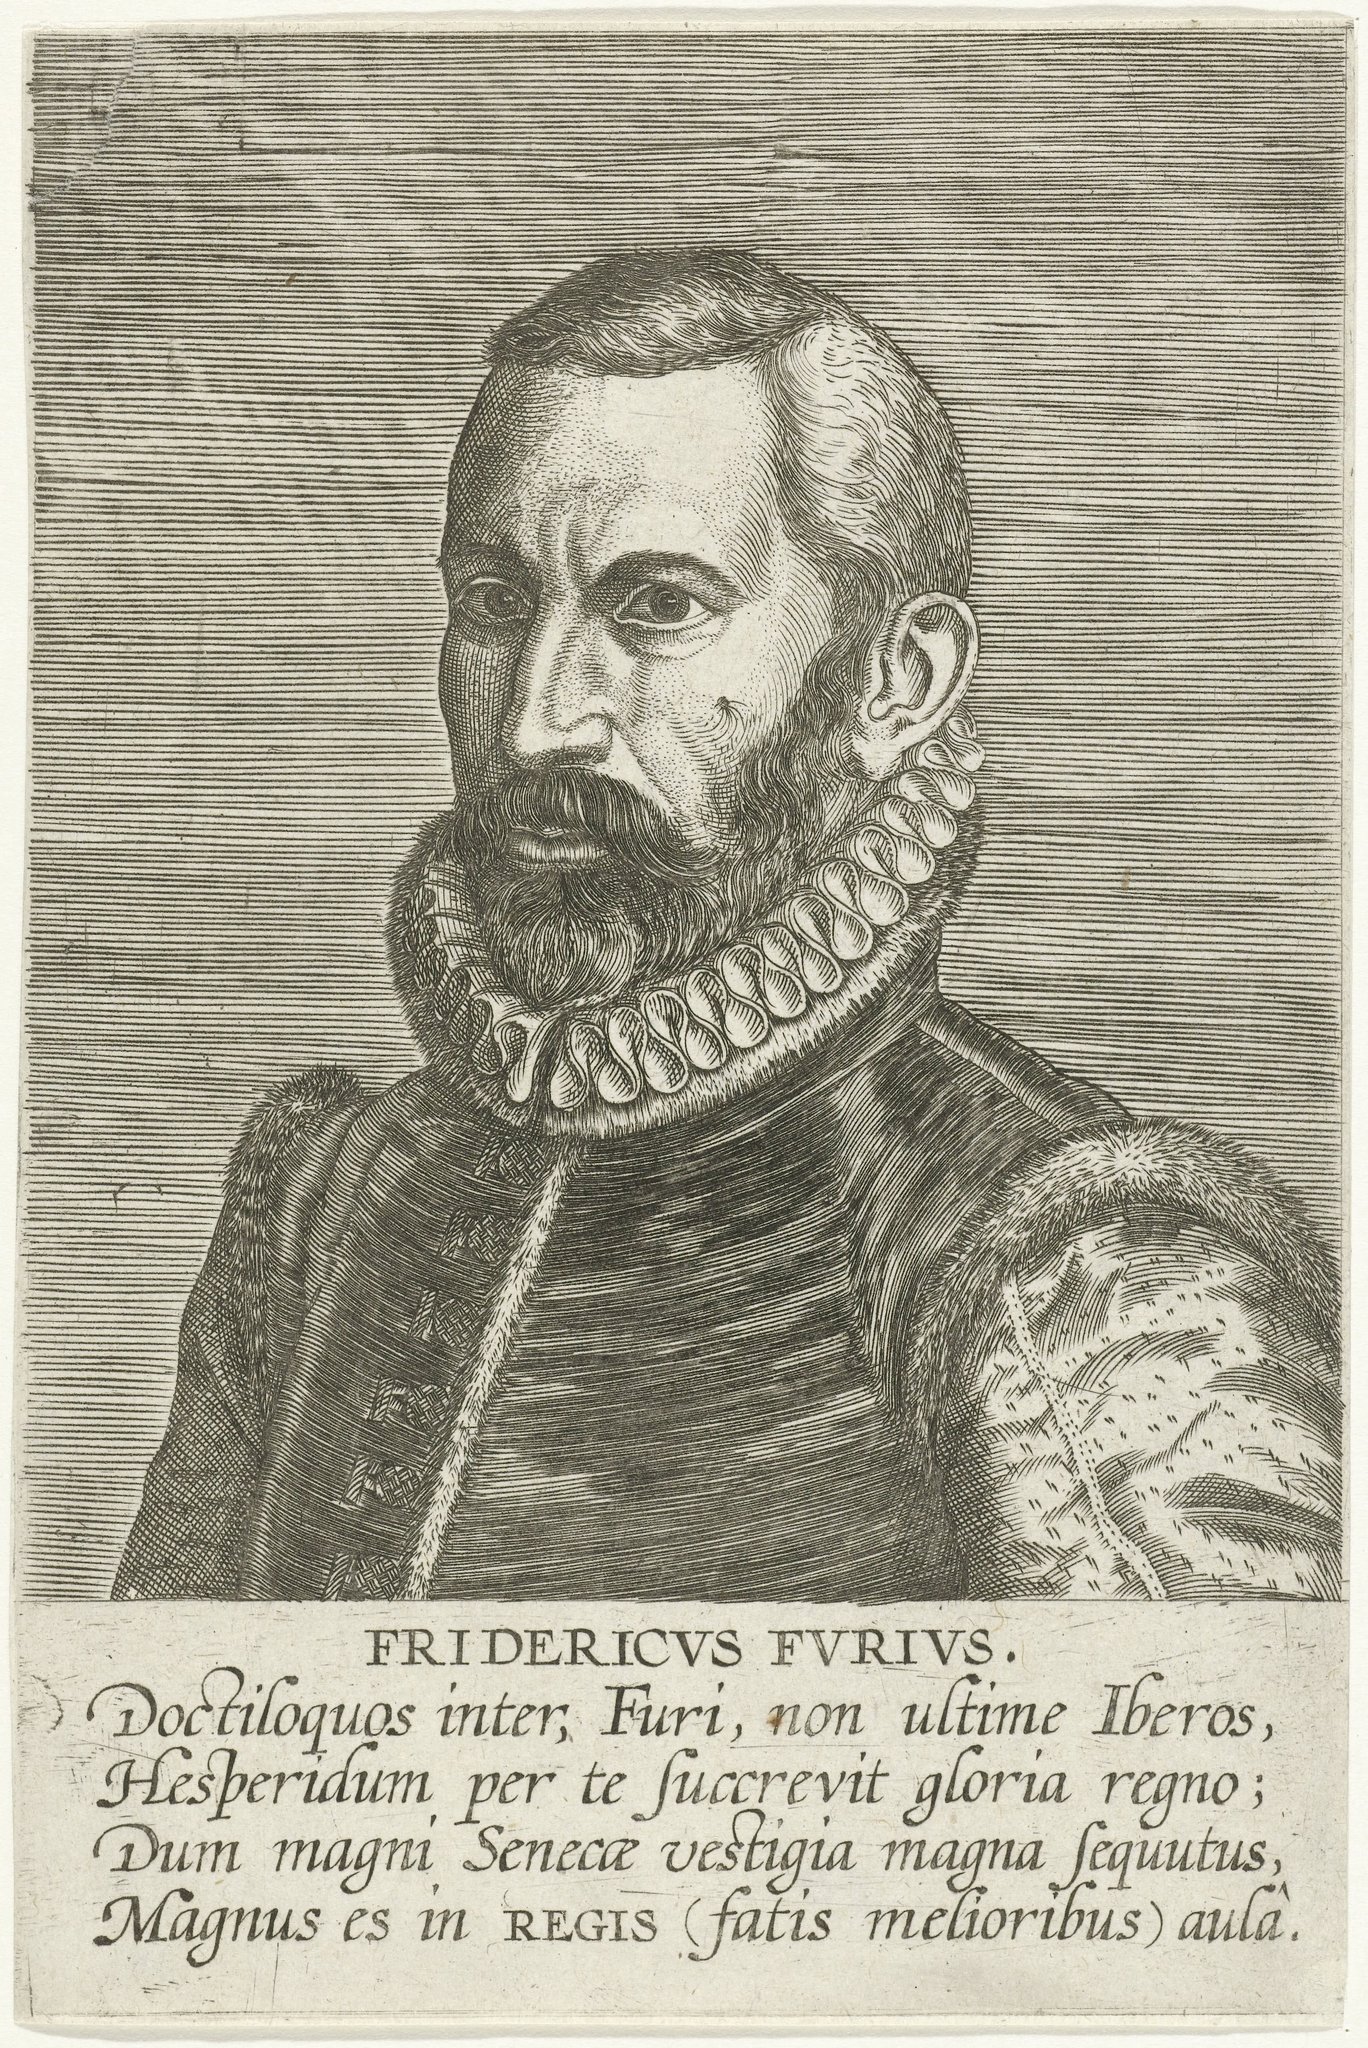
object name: print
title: Portret van Federico Furio y Ceriol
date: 1587-1606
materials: paper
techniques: engraving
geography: antwerp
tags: valencia, valladolid, historicus, federico furio y ceriol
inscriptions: collector's mark: Lugt 2228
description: Portret van Federico Furio y Ceriol, Spaanse humanist en historicus. Buste naar links. De prent heeft een Latijns onderschrift en maakt deel uit van een serie van beroemde geleerden.